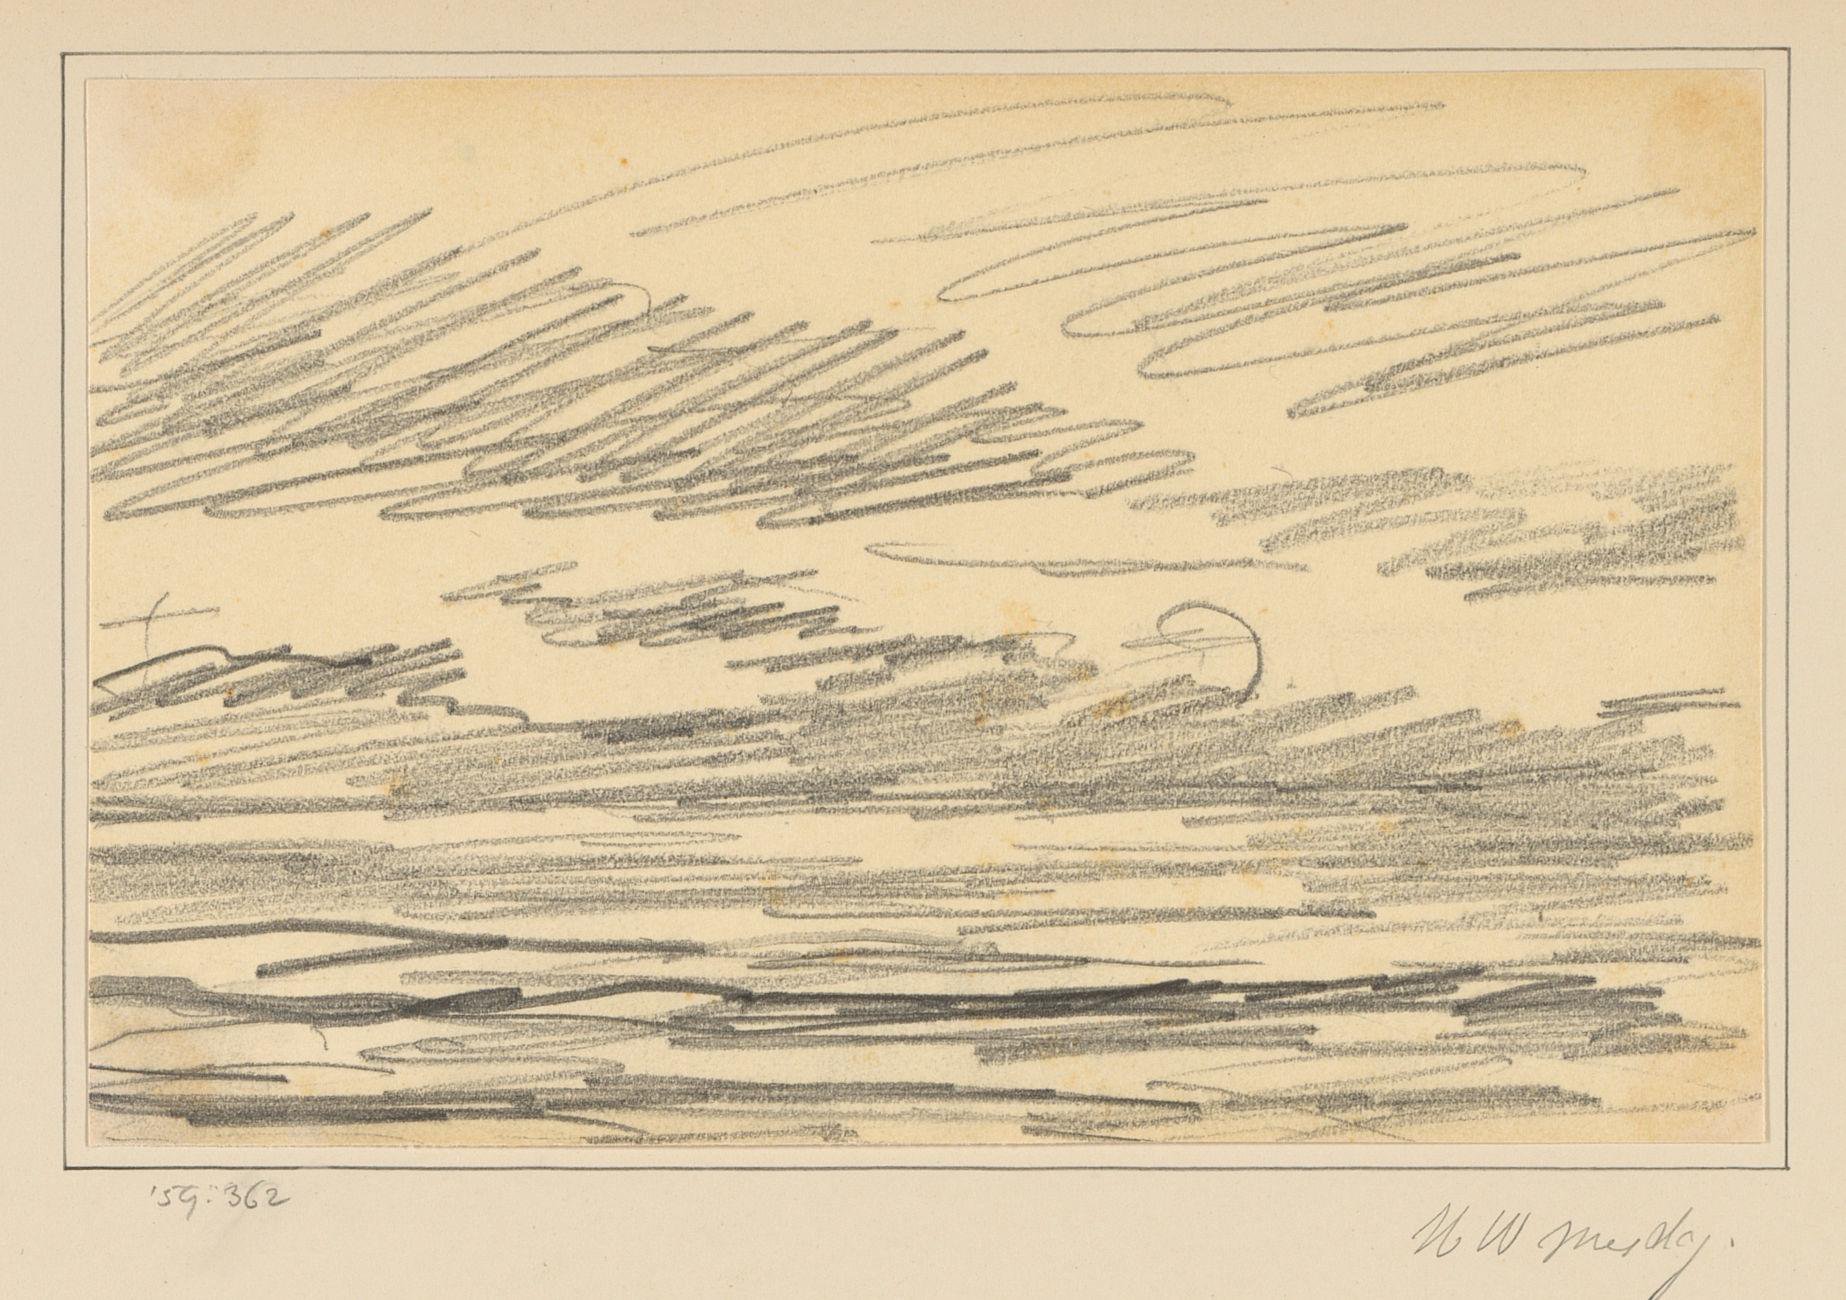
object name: drawing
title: Zeegezicht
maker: hendrik willem mesdag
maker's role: draughtsman, painter, print maker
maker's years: 1831-1915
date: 1831-1915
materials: paper, pencil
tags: sea (seascape)